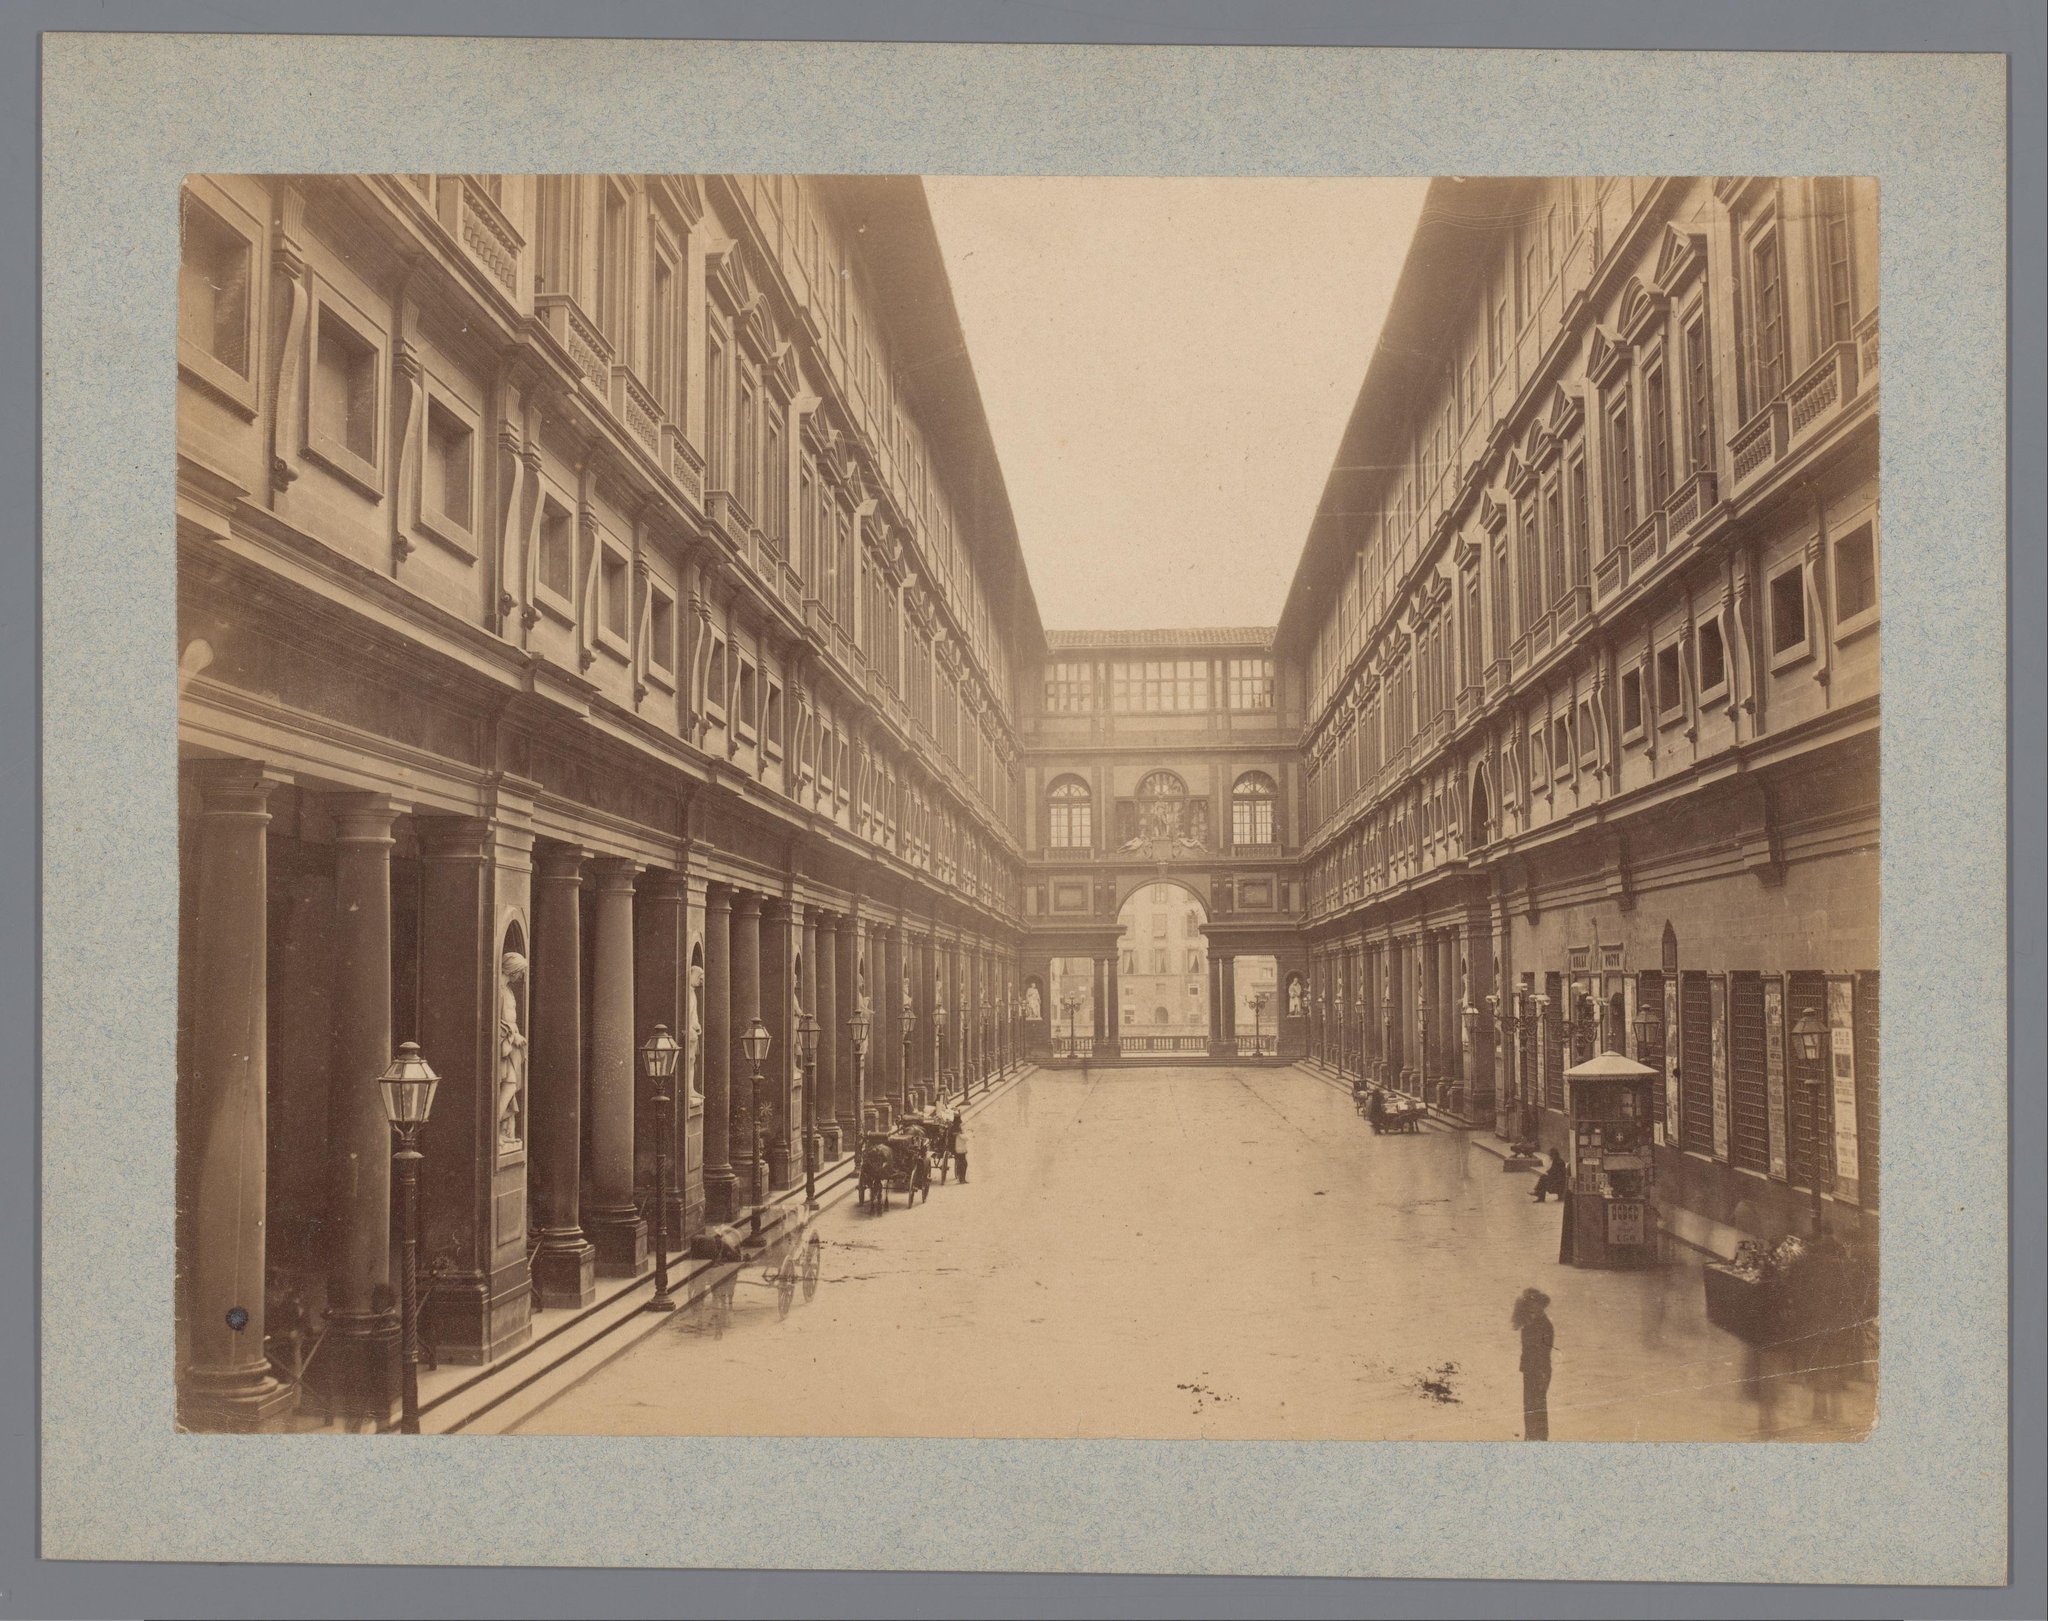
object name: photograph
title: Galleria degli Uffizi te Florence, Italië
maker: Anonymous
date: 1851-1900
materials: cardboard, paper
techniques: albumen print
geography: florence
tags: permanent exhibition, museum, exterior ~ representation of a building